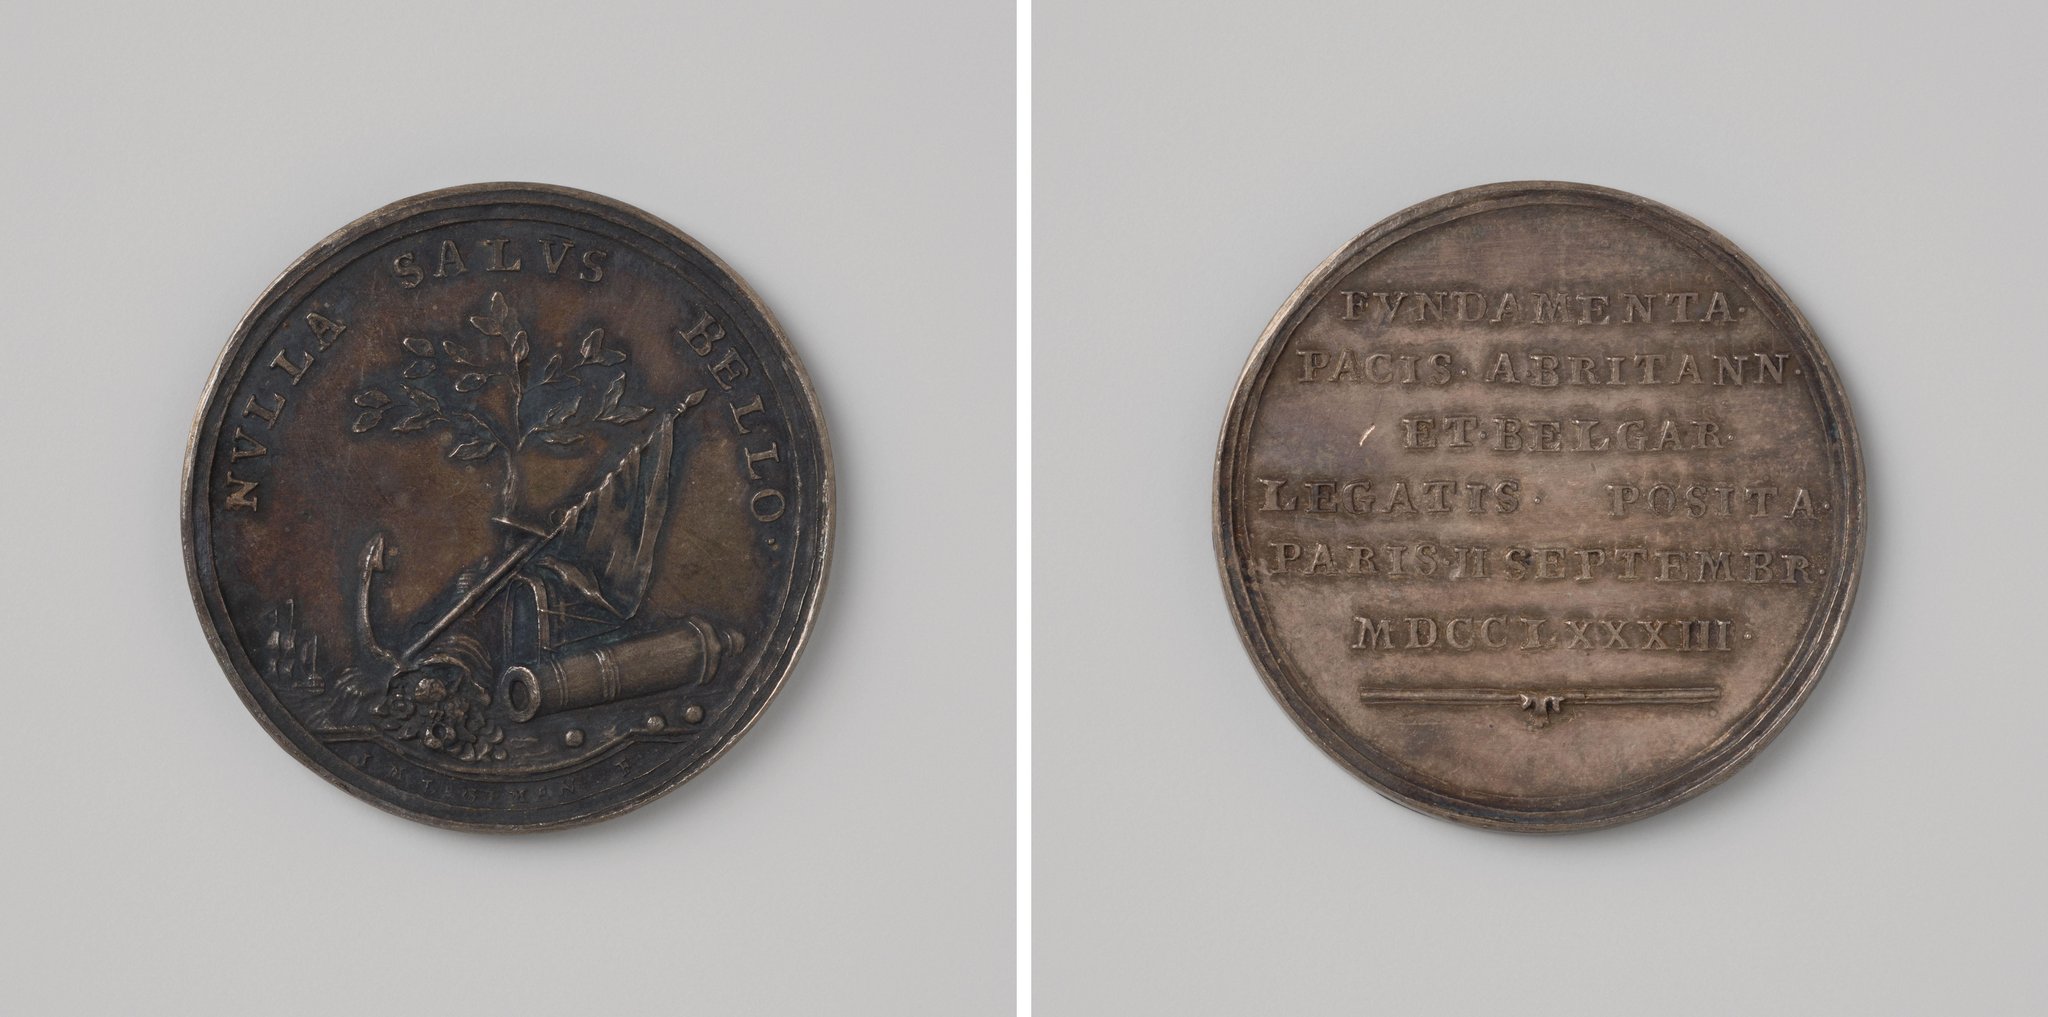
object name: history medal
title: Voorlopige vredesvoorwaaden tussen Engeland en de Republiek te Parijs gesloten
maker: johannes michiel lageman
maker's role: silversmith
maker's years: 1735-1809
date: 1783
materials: silver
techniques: striking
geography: amsterdam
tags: paris